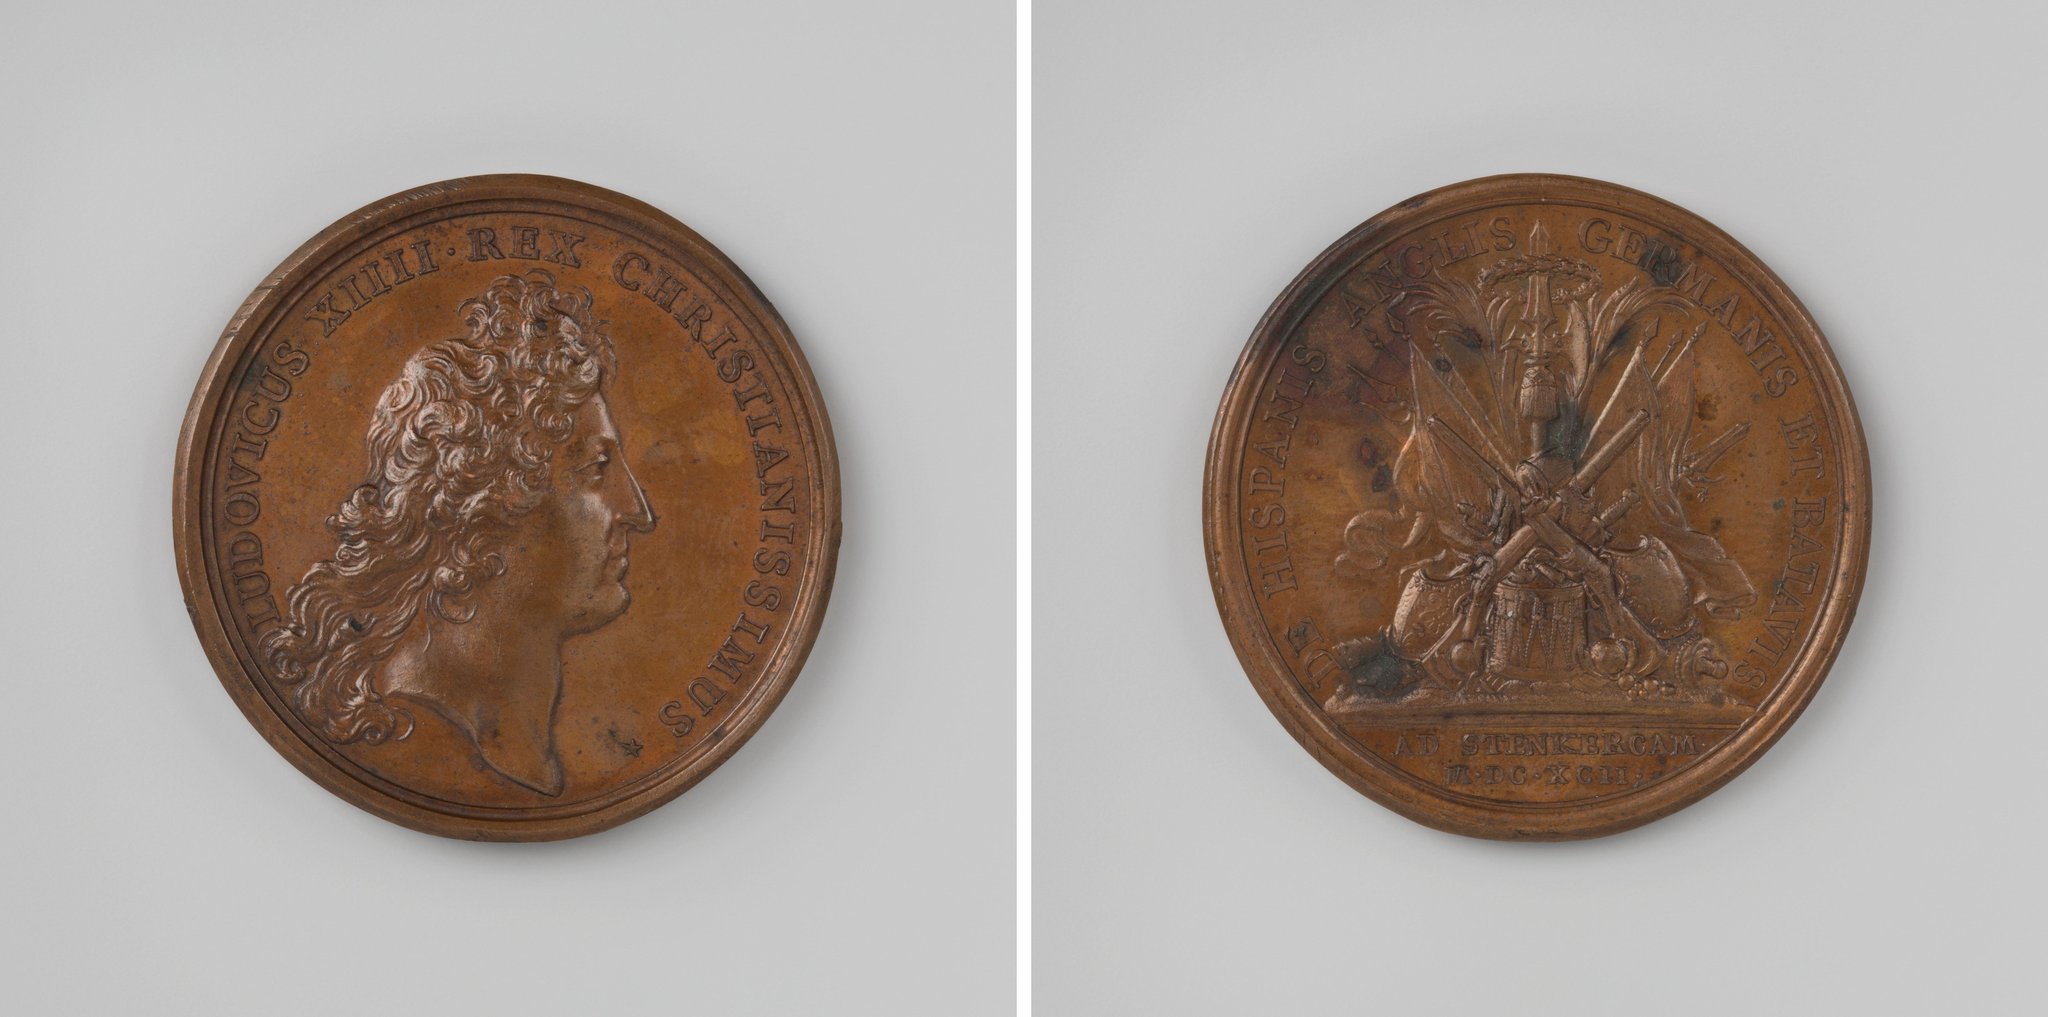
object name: history medal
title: Slag bij Steenkerken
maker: Anonymous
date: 1692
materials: bronze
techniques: striking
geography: paris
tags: lodewijk xiv (koning van frankrijk), henegouwen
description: Bronzen penning. Voorzijde: borststuk man binnen omschrift. Keerzijde: overwinningsstandaard opgebouwd uit wapentuig, vaandels, zegetakken en trom binnen omschrift; afsnede: opschrift